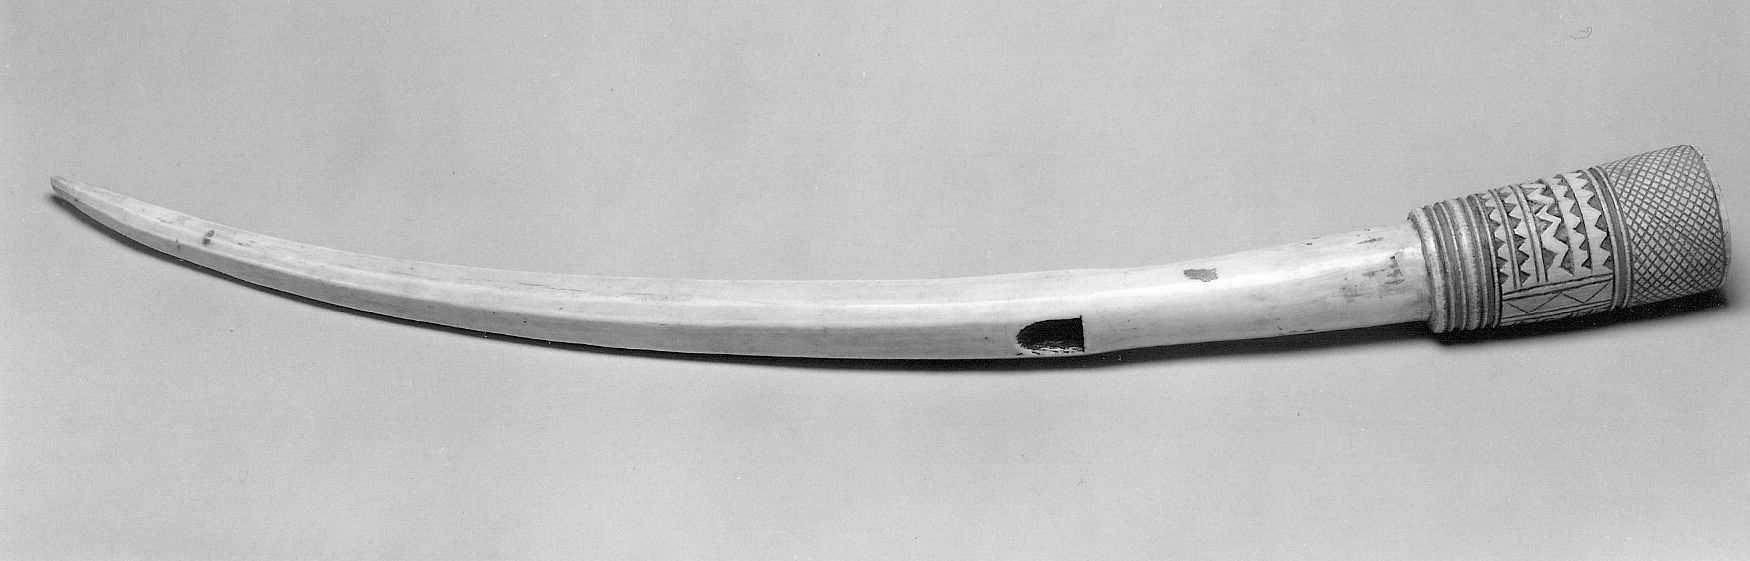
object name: horn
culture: igbo people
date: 1867-1900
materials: ivory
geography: nigeria